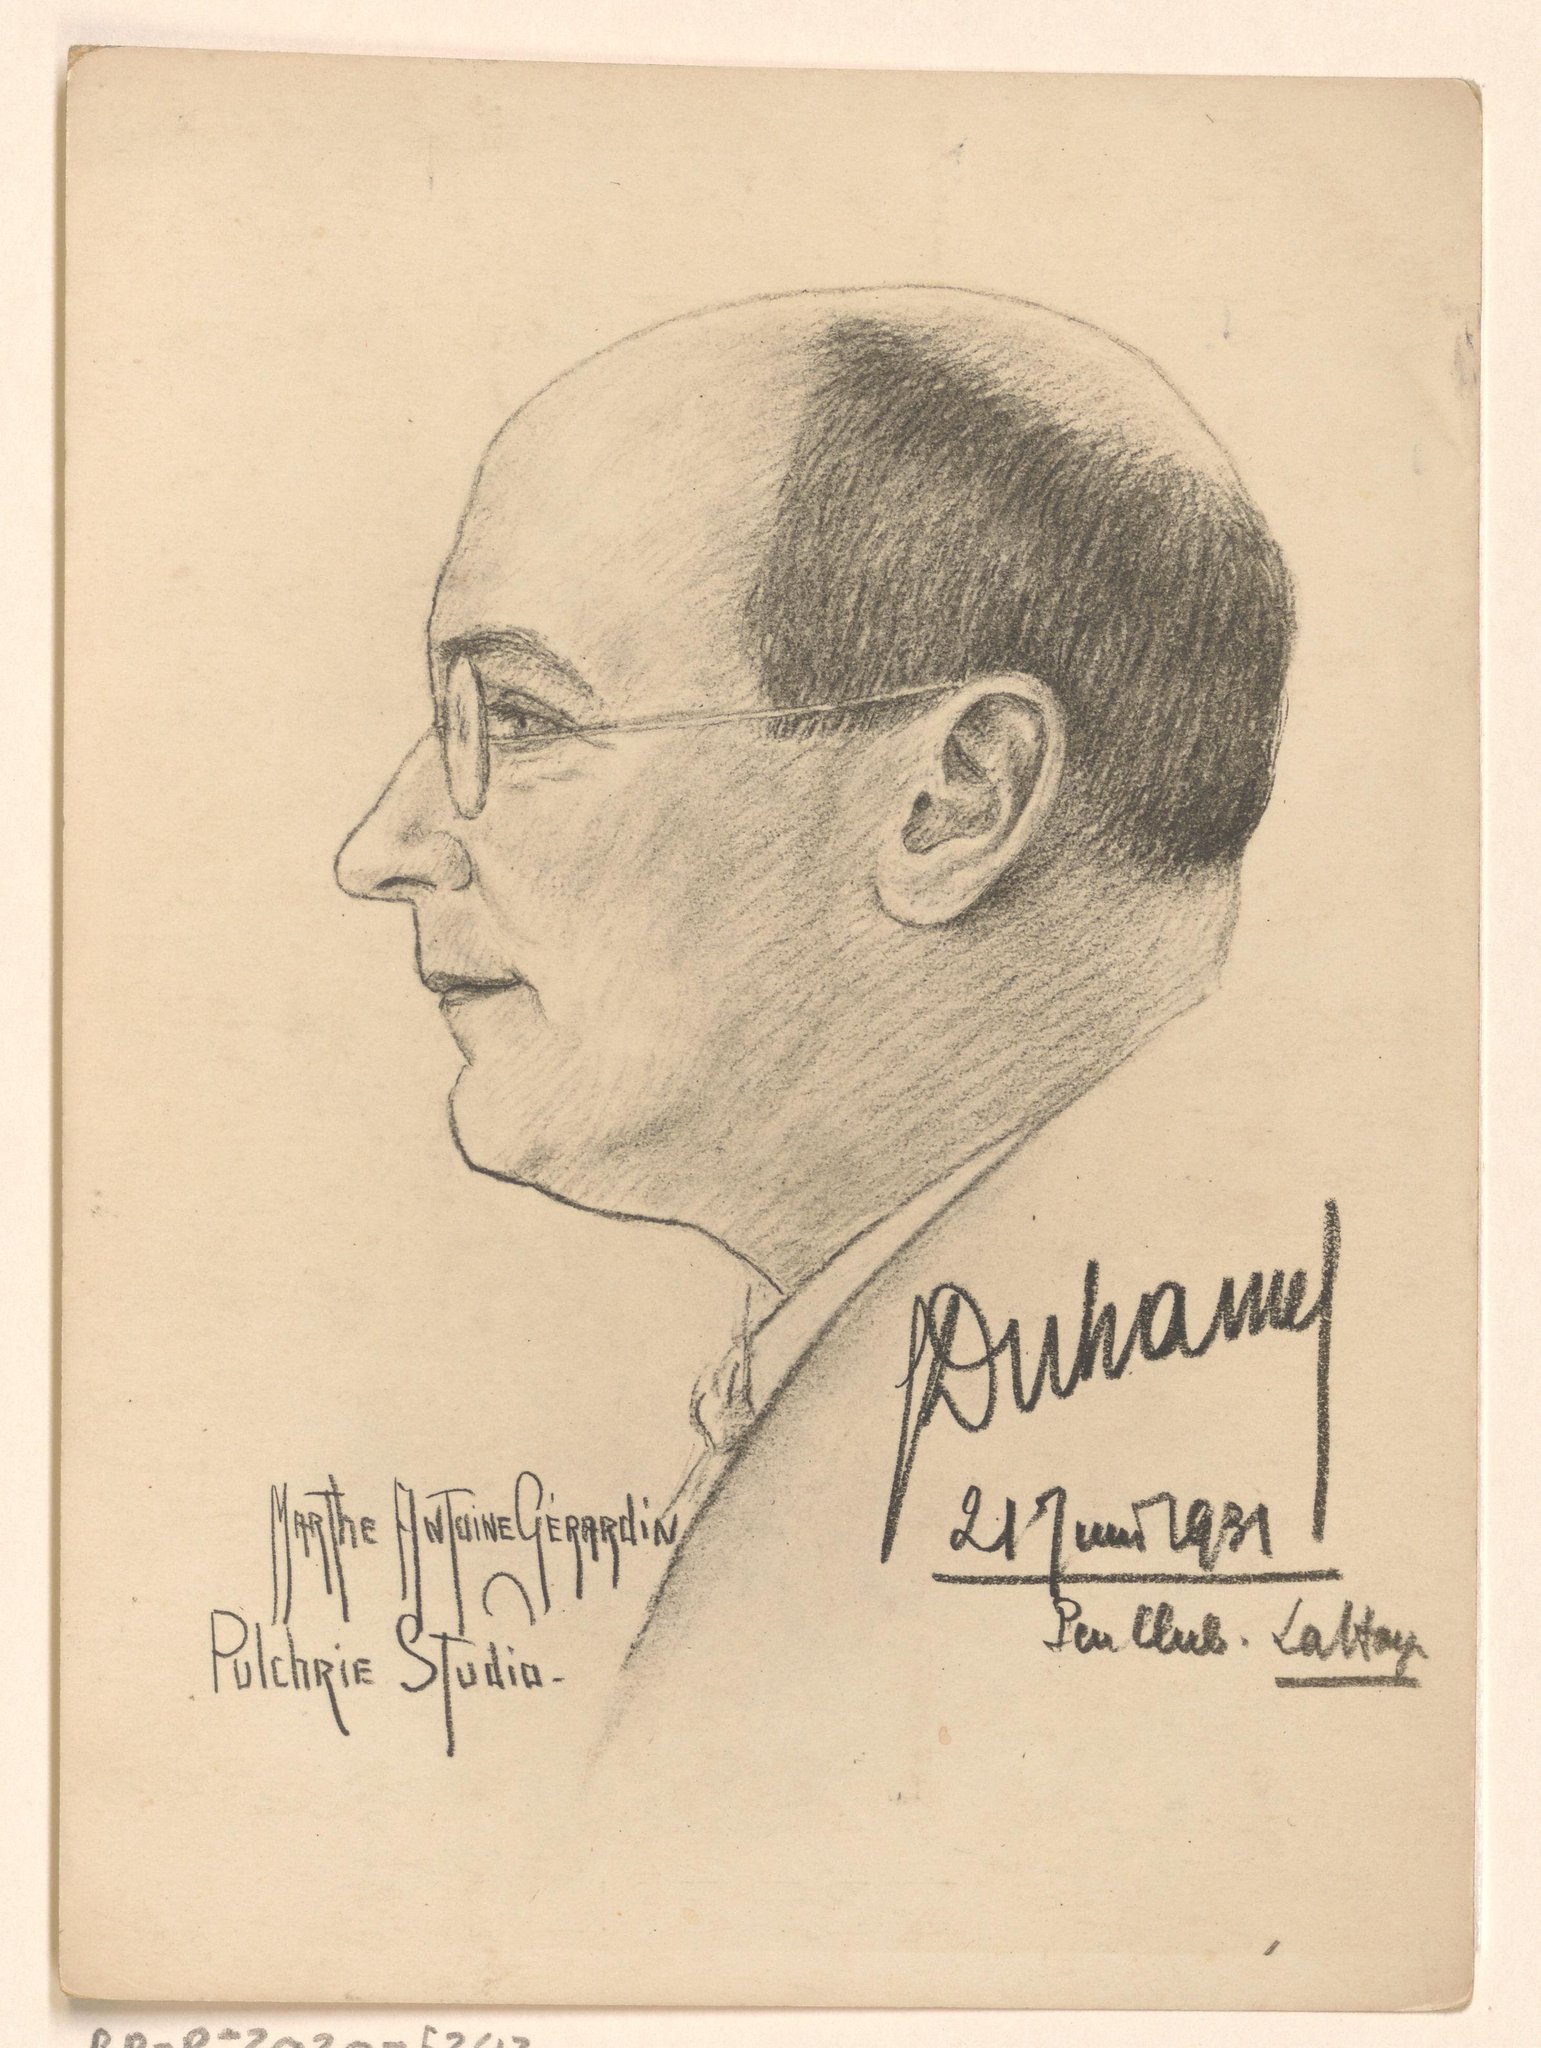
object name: print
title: Portret van Georges Duhamel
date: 1931-1966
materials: cardboard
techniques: lithograph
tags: paris, historical persons, portrait of a writer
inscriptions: inscription: ‘Georges Duhamel./ Hôte d'Honneur/ du "Pen Club"/ [...]/ [...] Marthe Antoine Gérardin’